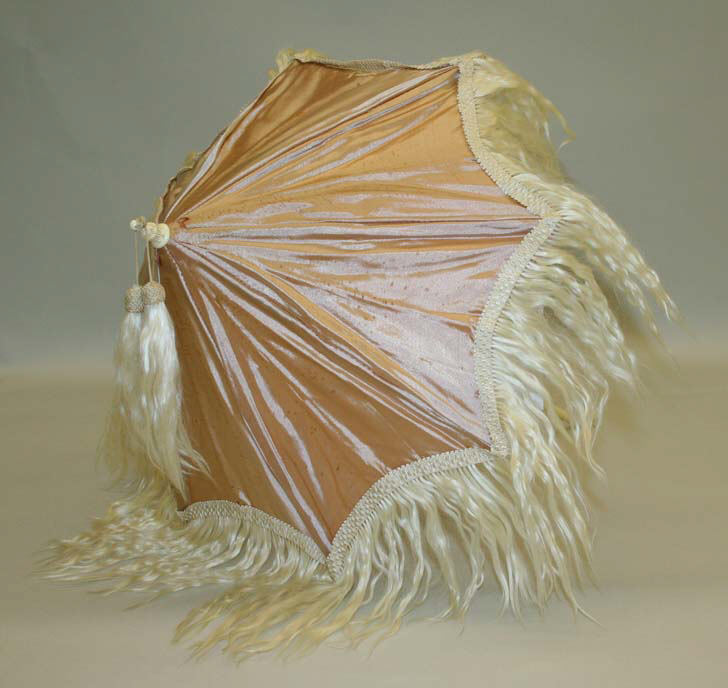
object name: parasol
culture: french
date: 1860-1869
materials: hair, ivory, metal, silk